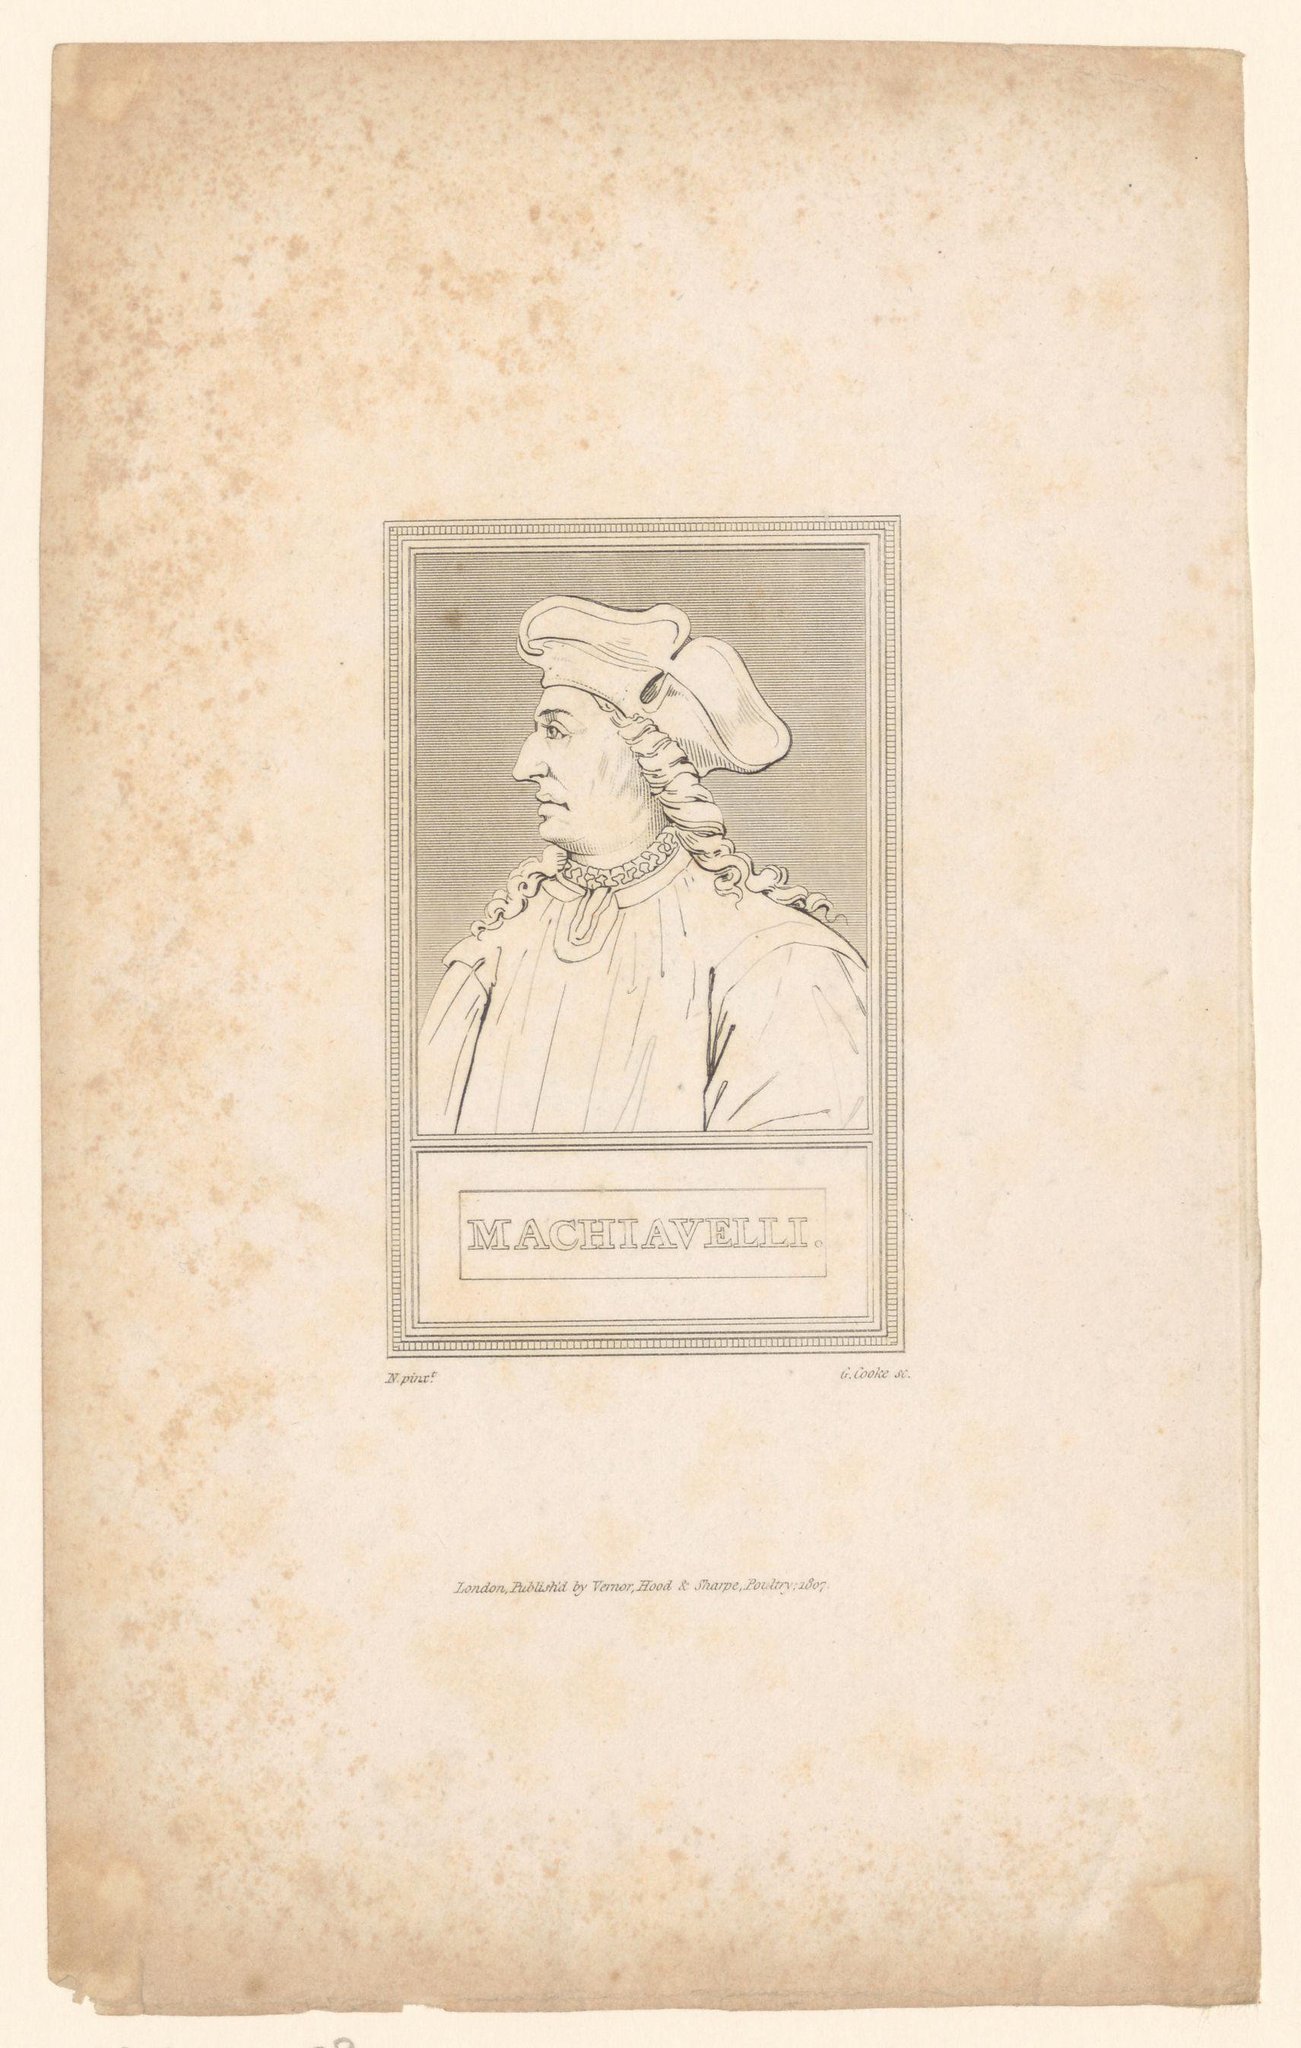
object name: book illustration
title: Machiavelli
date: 1807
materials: paper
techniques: etching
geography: london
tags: politician, historical persons, politician, e.g. party leader, scholar, philosopher (+ portrait of scholar, scientist)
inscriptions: collector's mark: Lugt 2228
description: Prent uit: The Historic Gallery of Portraits and Paintings (...). Londen: Vernor, Hood & Sharpe, 1807, dl. 1.